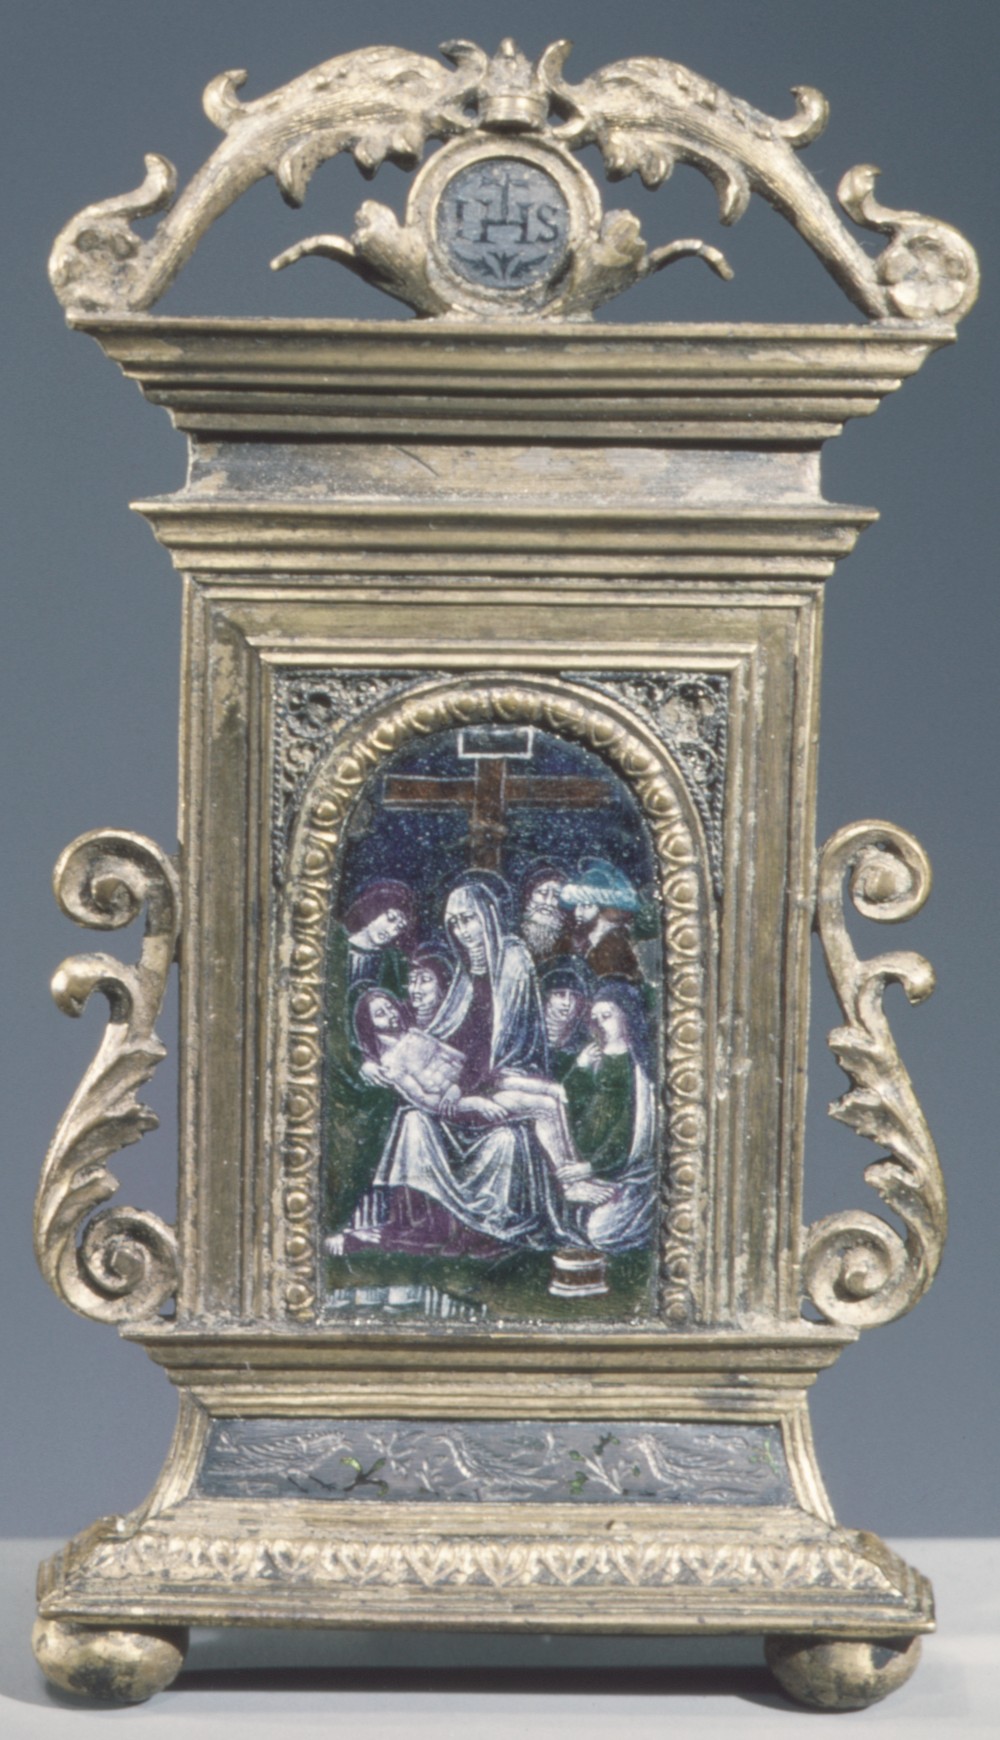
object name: pax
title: Pietà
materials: enamel, gilt bronze, silver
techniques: enamel, filigree, painting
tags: virgin mary,cross,jesus,death